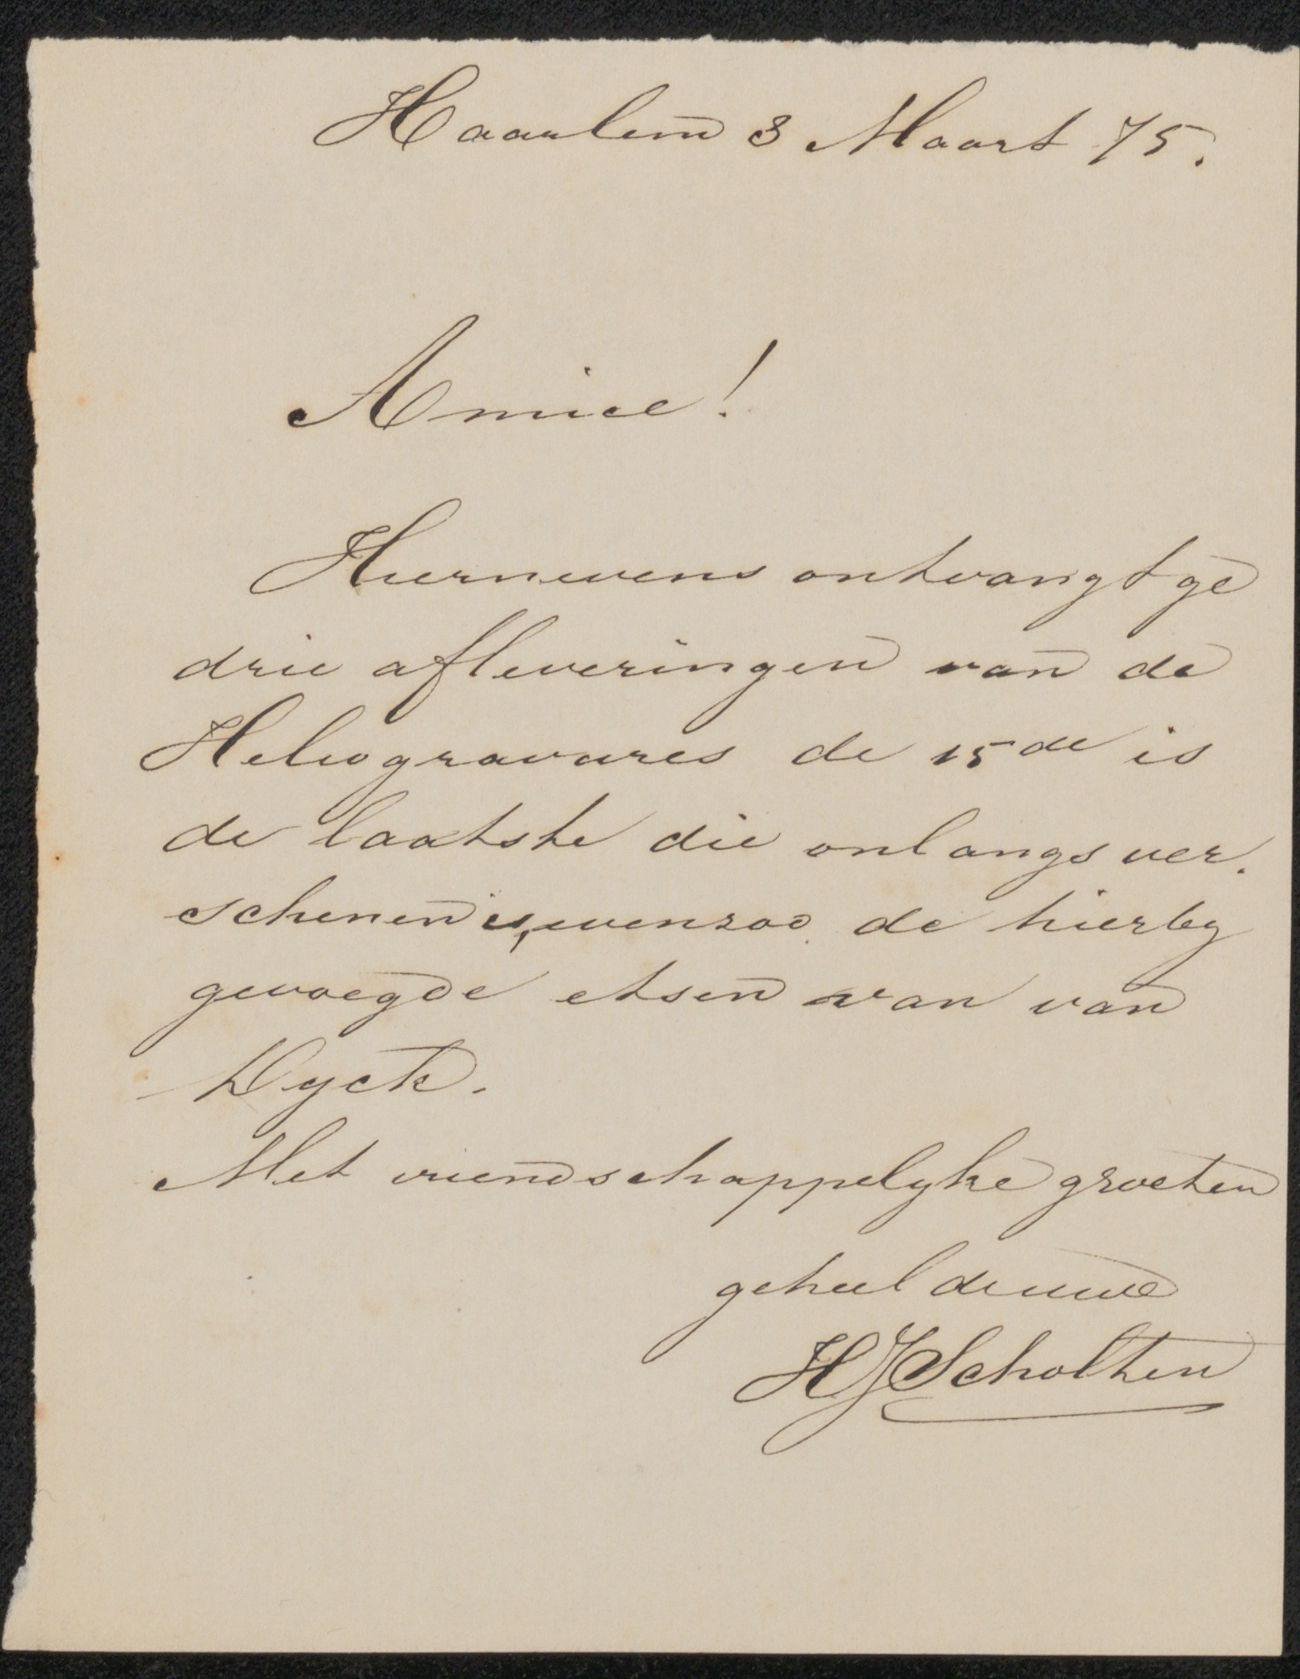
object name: letter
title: Brief aan anoniem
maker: hendrik jacobus scholten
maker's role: draughtsman, painter, print maker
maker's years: 1824-1907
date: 1875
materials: ink, paper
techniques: pen, writing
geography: haarlem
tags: the graphic arts